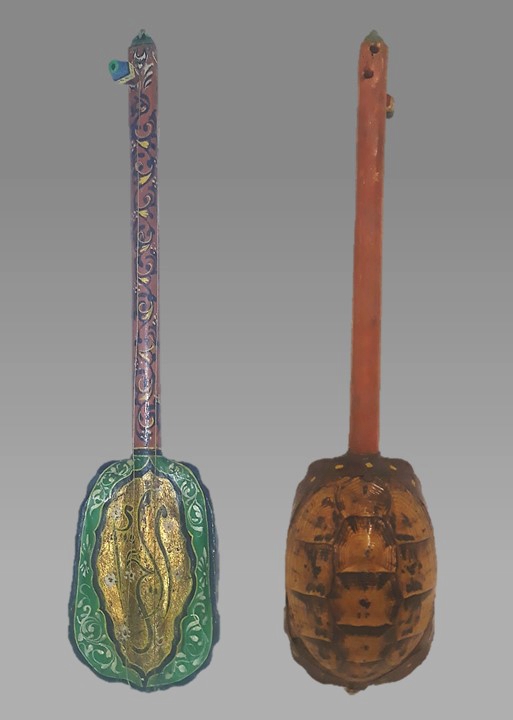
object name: guenbri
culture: algerian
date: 1867-1900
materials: shell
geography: algeria